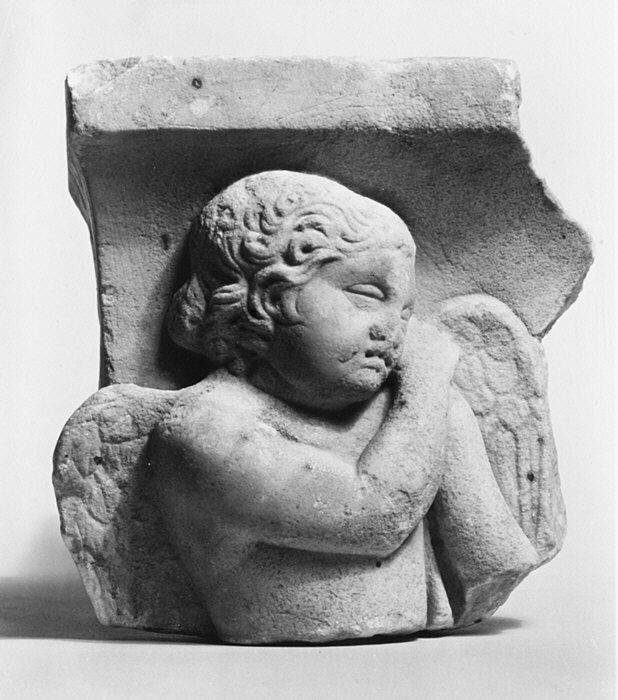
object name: sarcophagus fragment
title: Marble sarcophagus fragment: Eros leaning on a reversed torch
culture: roman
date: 134-166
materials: marble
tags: eros